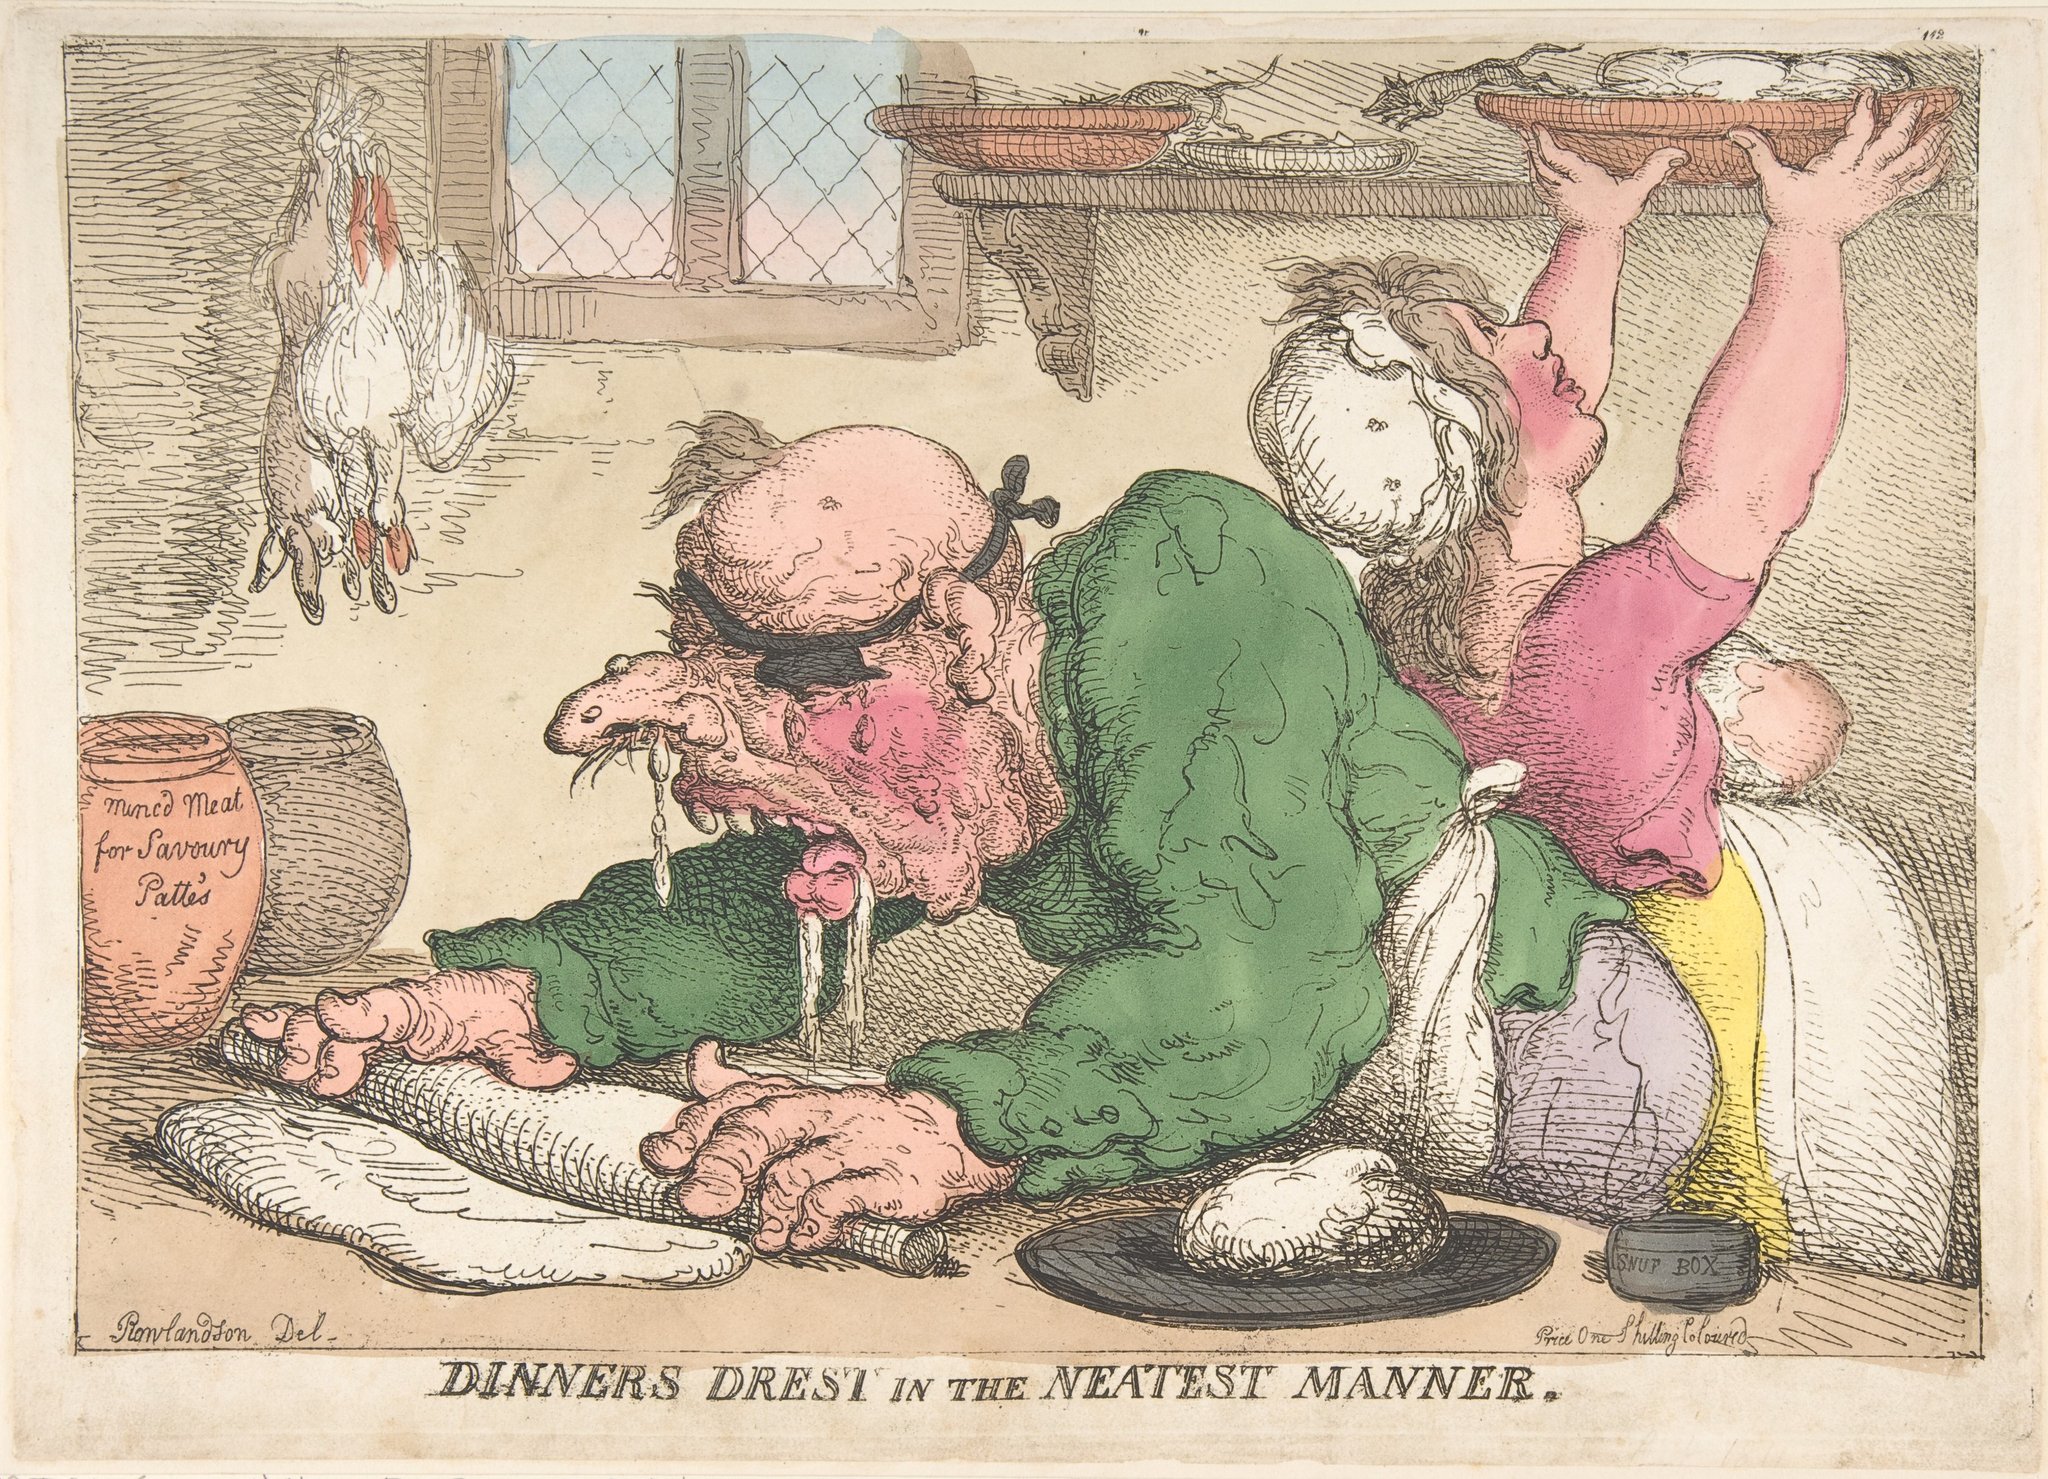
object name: print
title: Dinners Drest in the Neatest Manner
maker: thomas rowlandson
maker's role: artist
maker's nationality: british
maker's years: 1757-1827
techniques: etching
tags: satire,kitchens,men,women,mice,servants